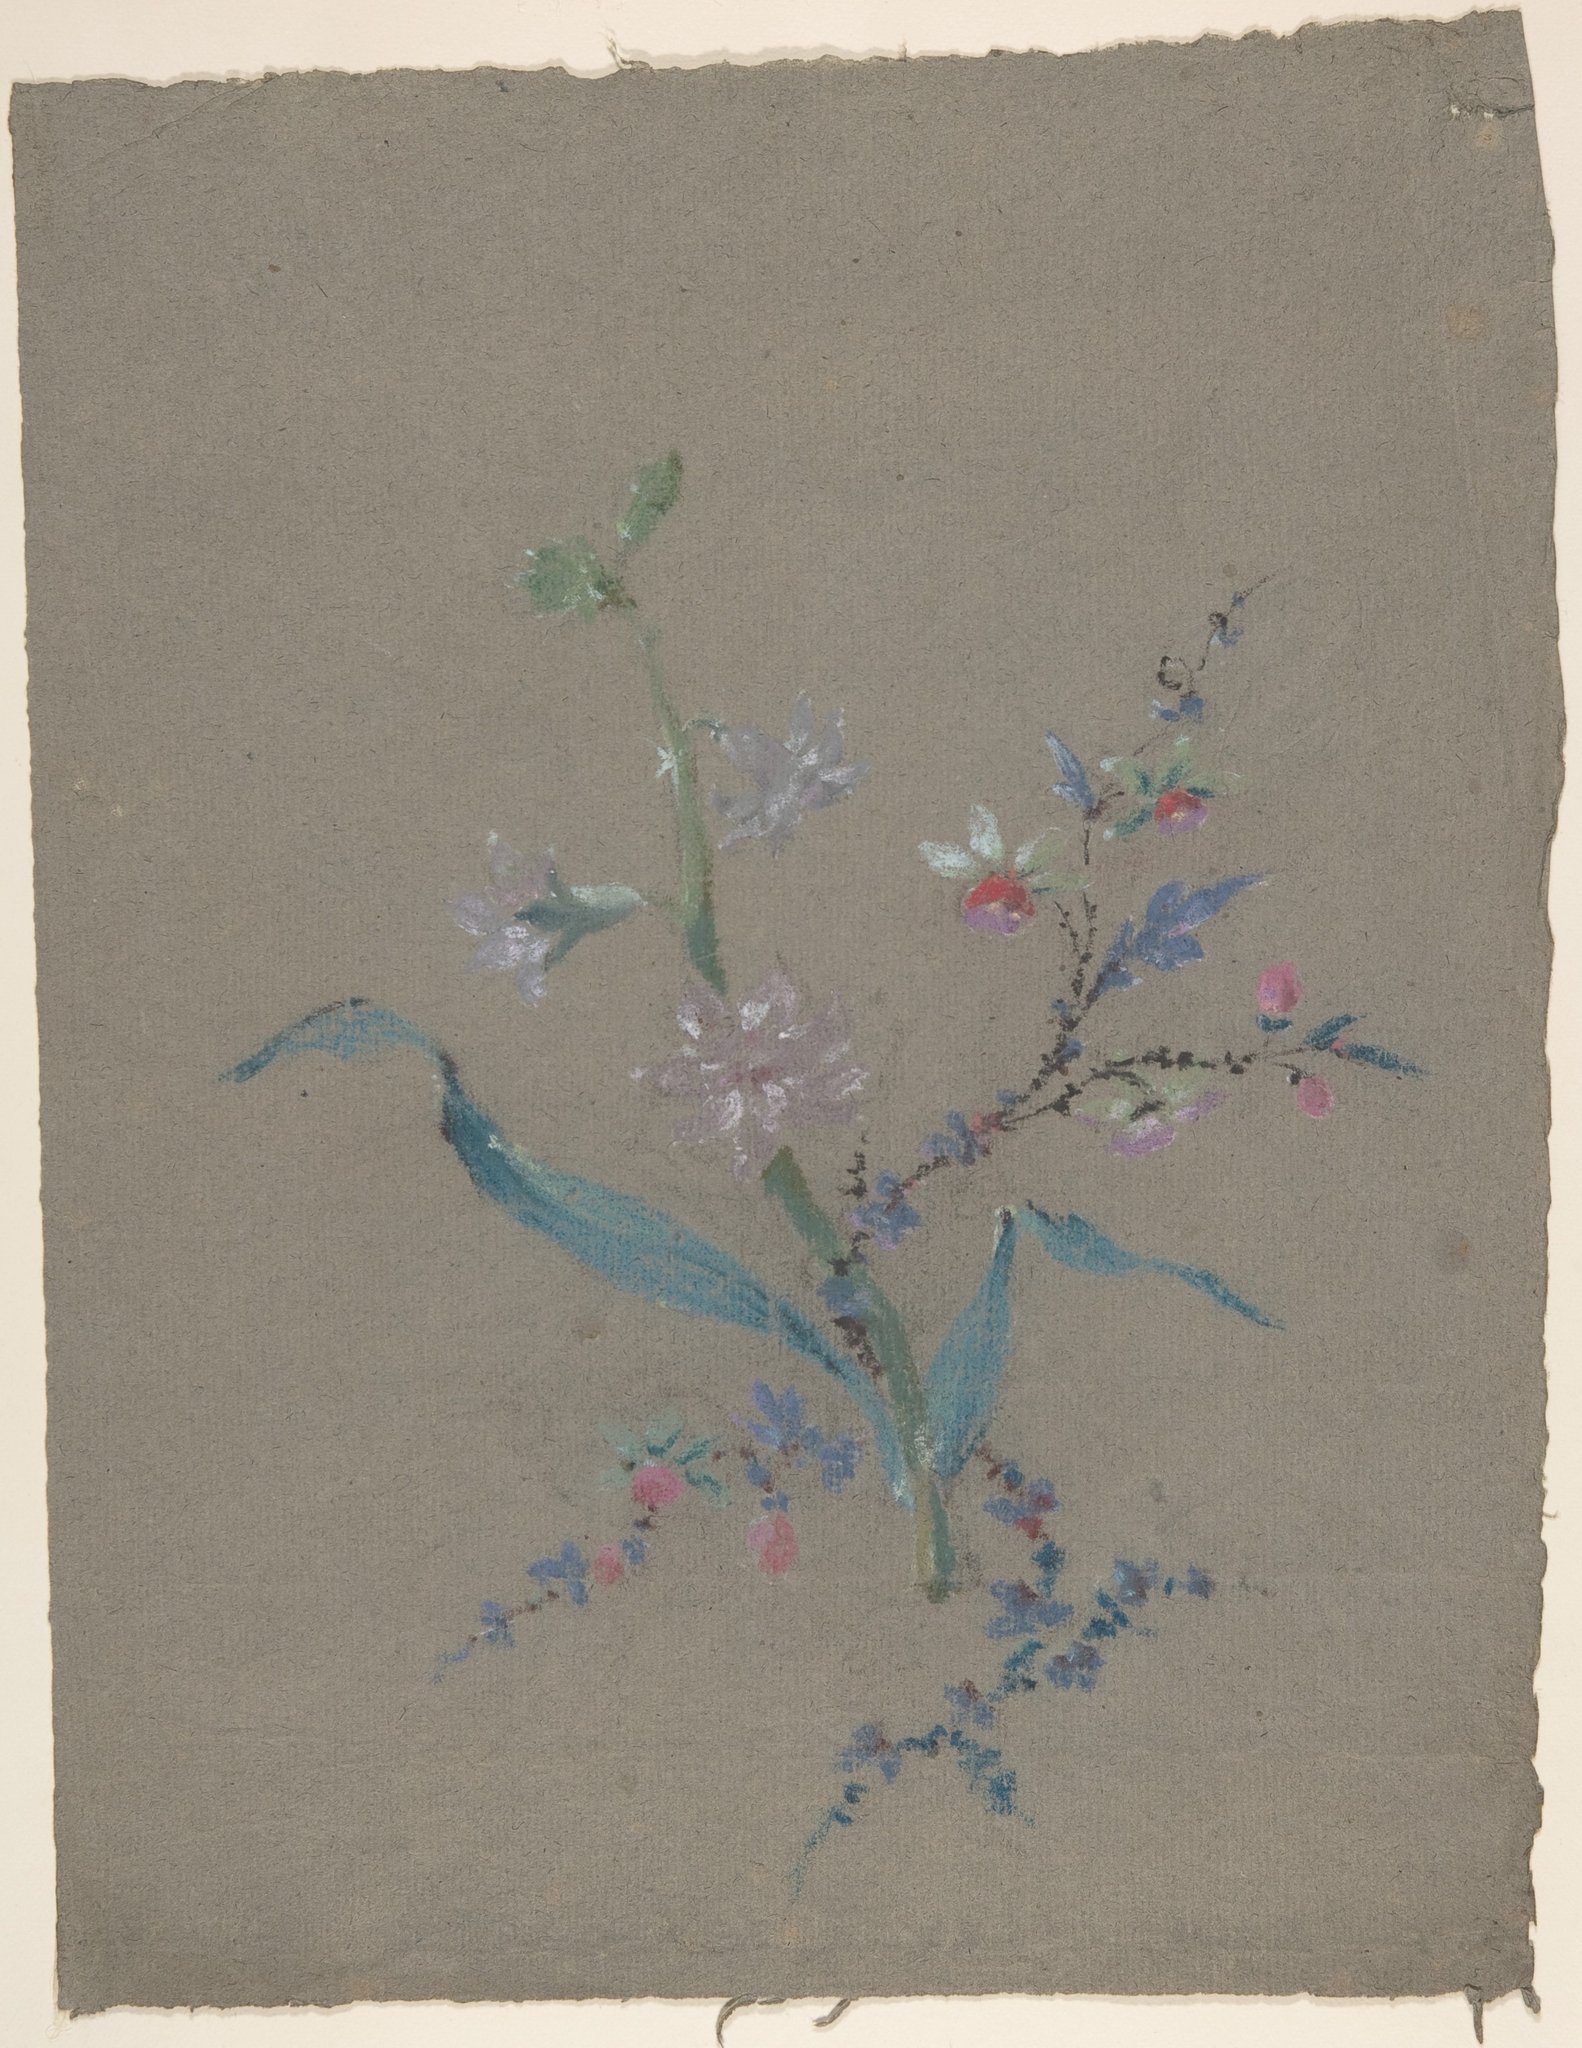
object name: drawing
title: Floral Design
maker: jean françois bony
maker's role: artist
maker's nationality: french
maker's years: 1760-1825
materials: paper, pastel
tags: flowers,leaves